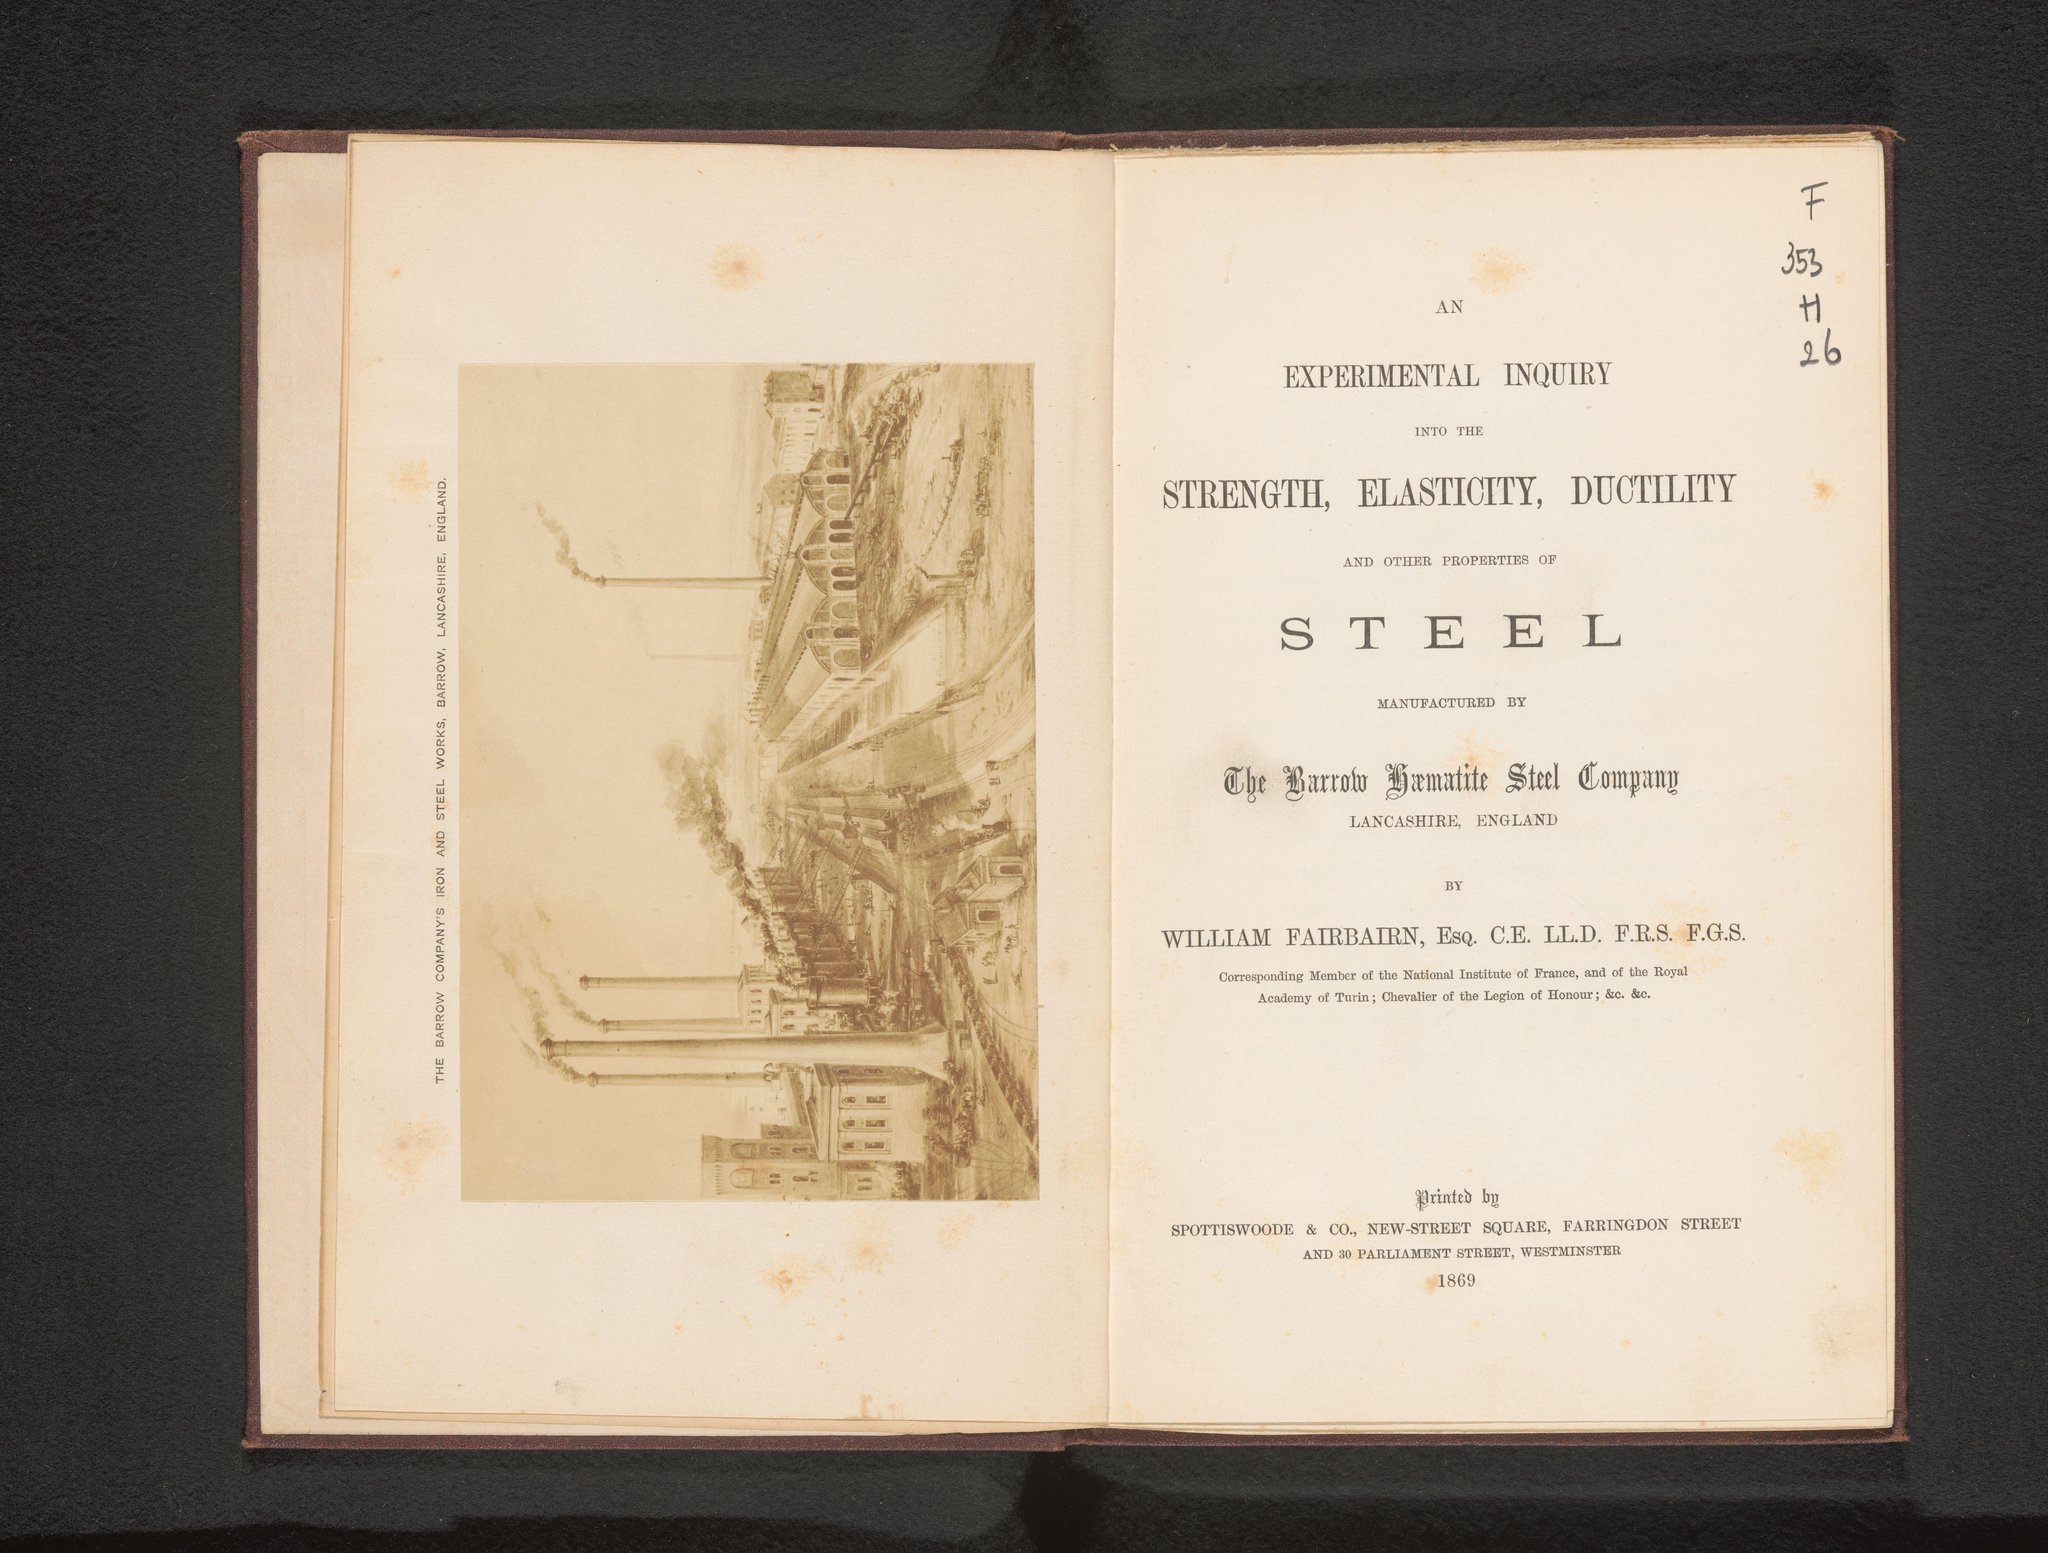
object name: book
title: An experimental inquiry into the strenghth, elasticity, ductility and other properties of steel manufactured by The Barrow Haematite Steel Company, Lancaster, England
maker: william fairbairn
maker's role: engineer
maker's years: 1789-1874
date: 1869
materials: linen, paper, photographic support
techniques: albumen print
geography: london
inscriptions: inscription: ‘A mon cher Avi[...] ami Henri de Loriol avec les compliments affecturde [...] tout [..]ioreé [...]’